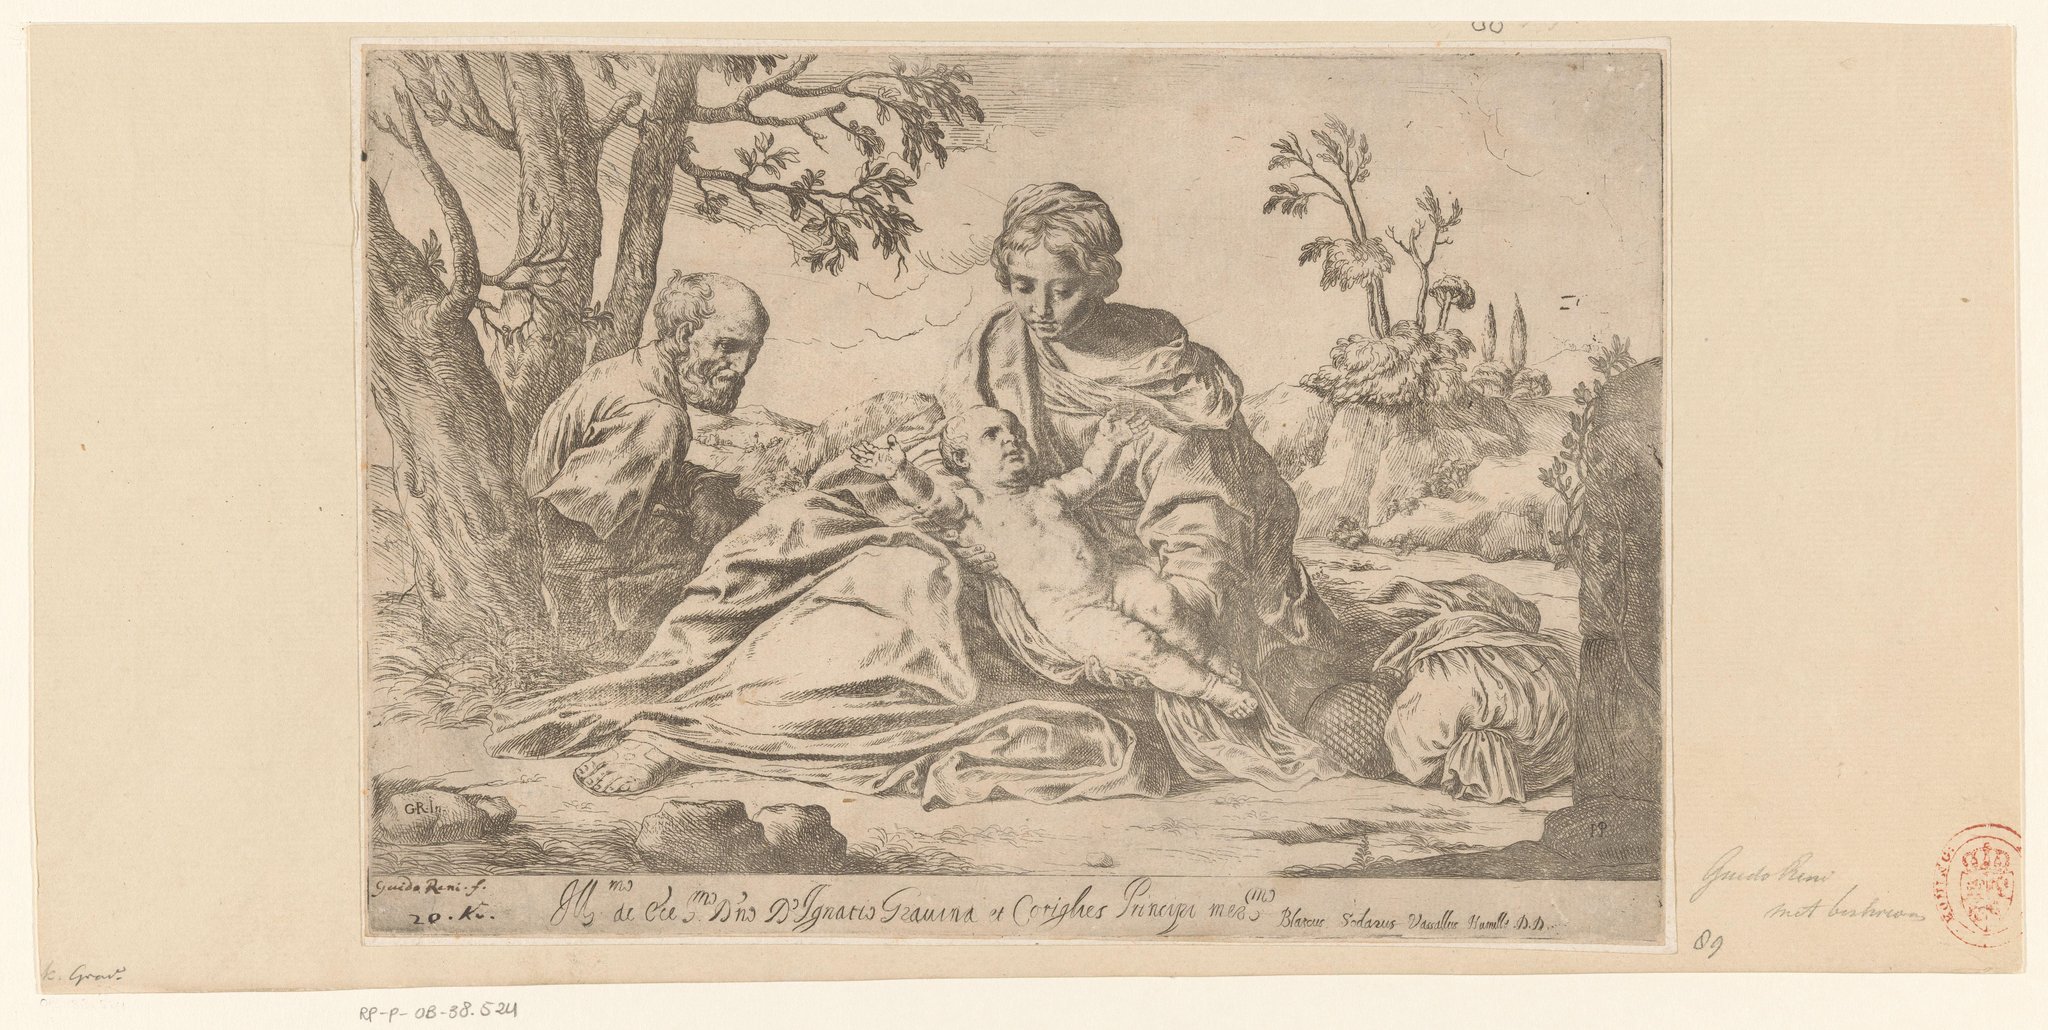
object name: print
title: Rest on the Flight into Egypt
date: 1600-1699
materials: paper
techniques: etching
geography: italy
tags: rest on the flight into egypt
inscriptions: collector's mark: Lugt 240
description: De Heilige Familie rustend in een landschap. Maria zit met het Christuskind op schoot. Links zit Jozef.